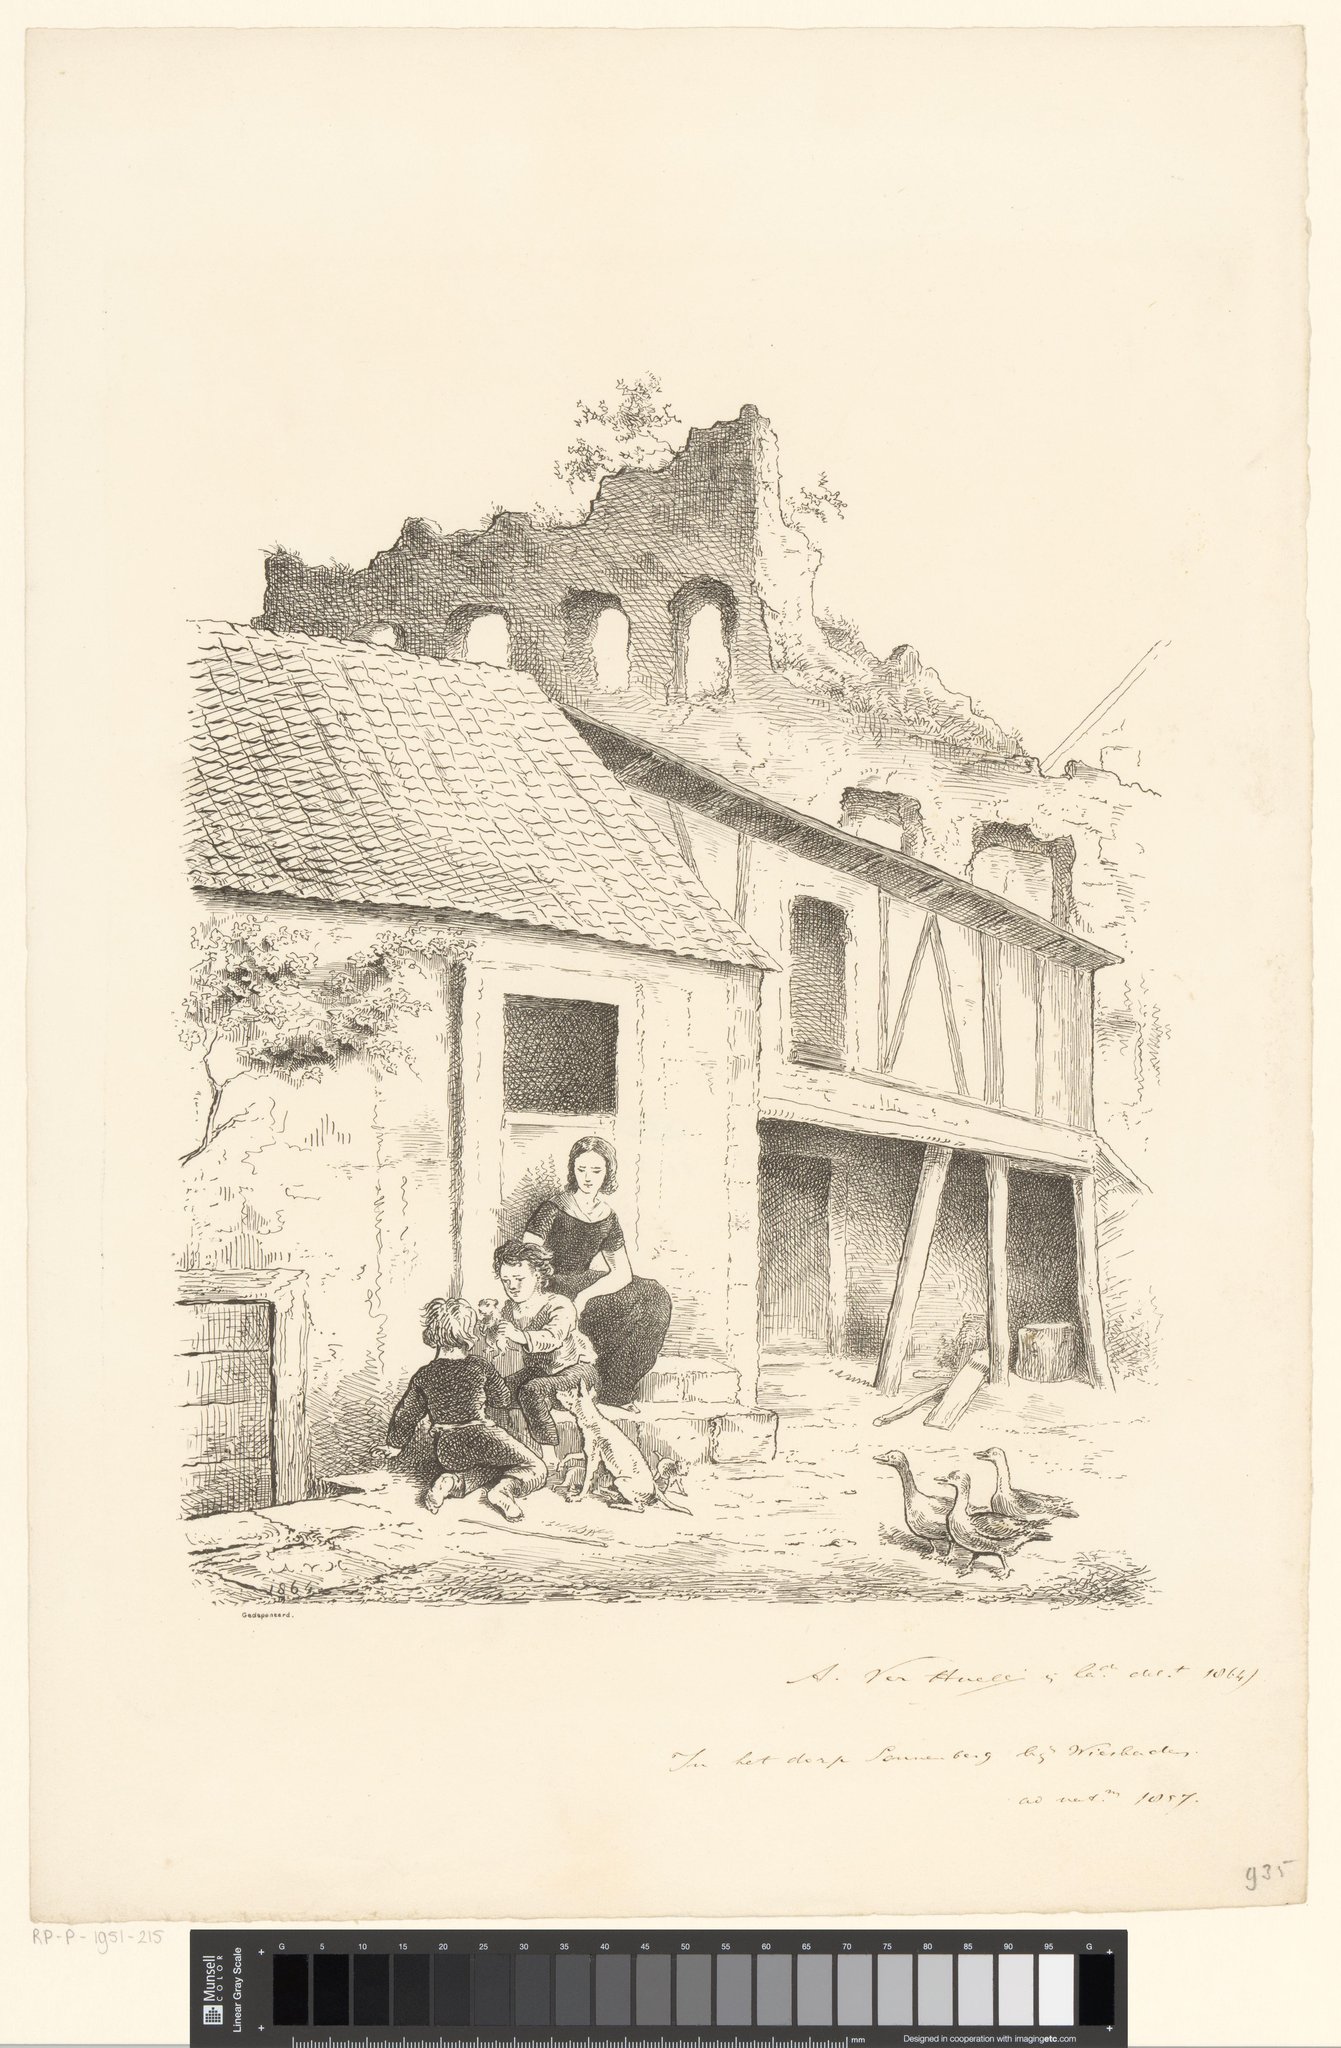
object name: print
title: Uit het verleden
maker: alexander ver huell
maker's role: draughtsman, print maker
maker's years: 1822-1897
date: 1864-1866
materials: paper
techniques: lithograph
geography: arnhem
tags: mother and child(ren), woman and child(ren) (family group), dog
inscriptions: : ‘Gedeponeerd.’, collector's mark: Lugt 2228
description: Een vrouw zit met haar twee kinderen op de stoep voor haar huis in het dorp Sonnenberg bij Wiesbaden. De kinderen spelen met de puppy's van de hond die naast hen zit. In de achtergrond een ruïne.